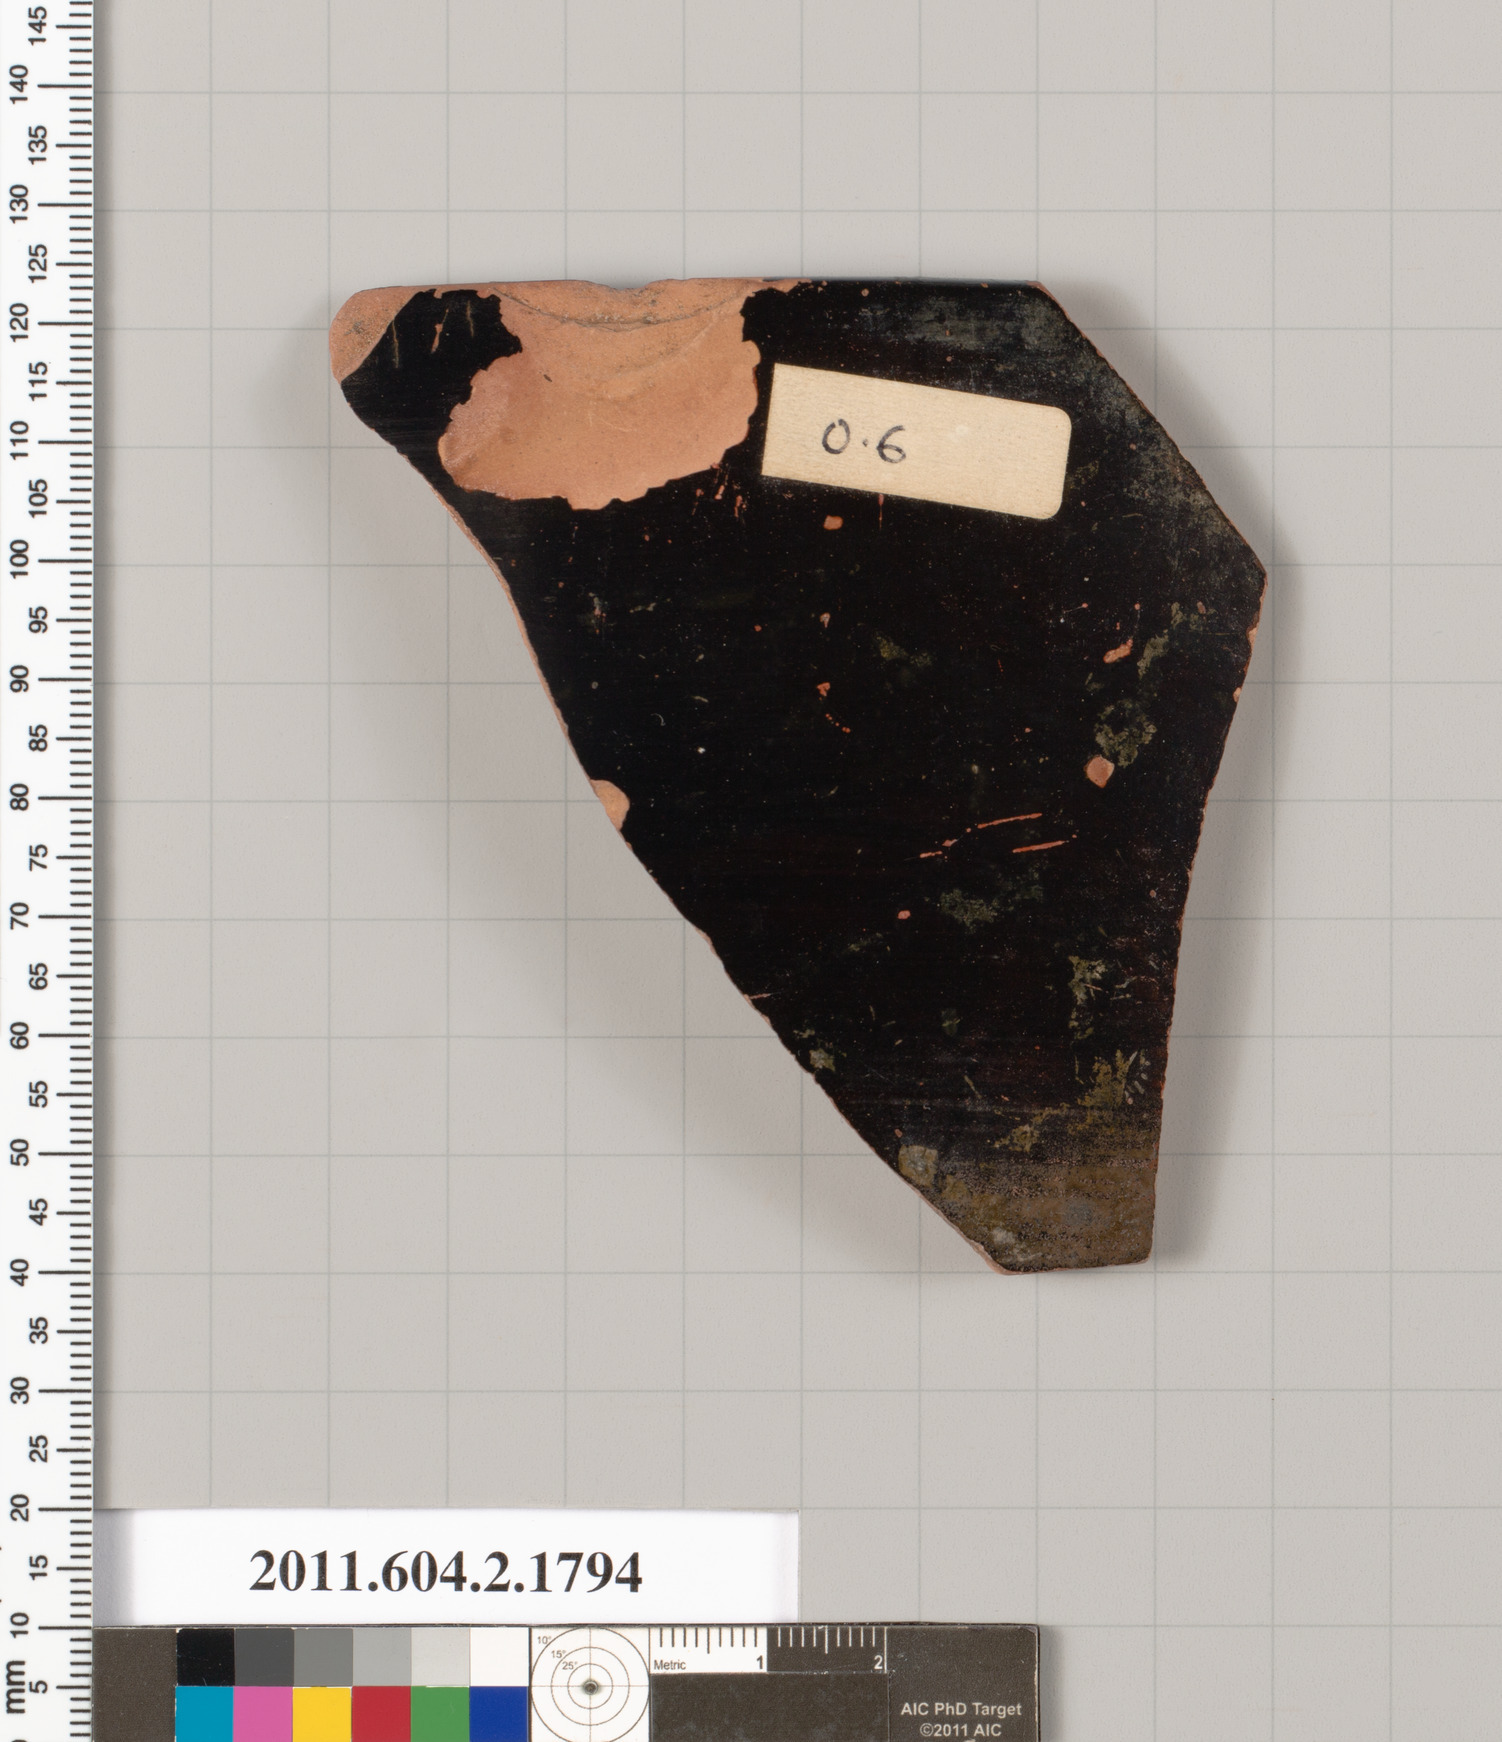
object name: skyphos fragment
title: Terracotta rim fragment of a skyphos (deep drinking cup)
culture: greek, attic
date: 450-401 BCE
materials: terracotta